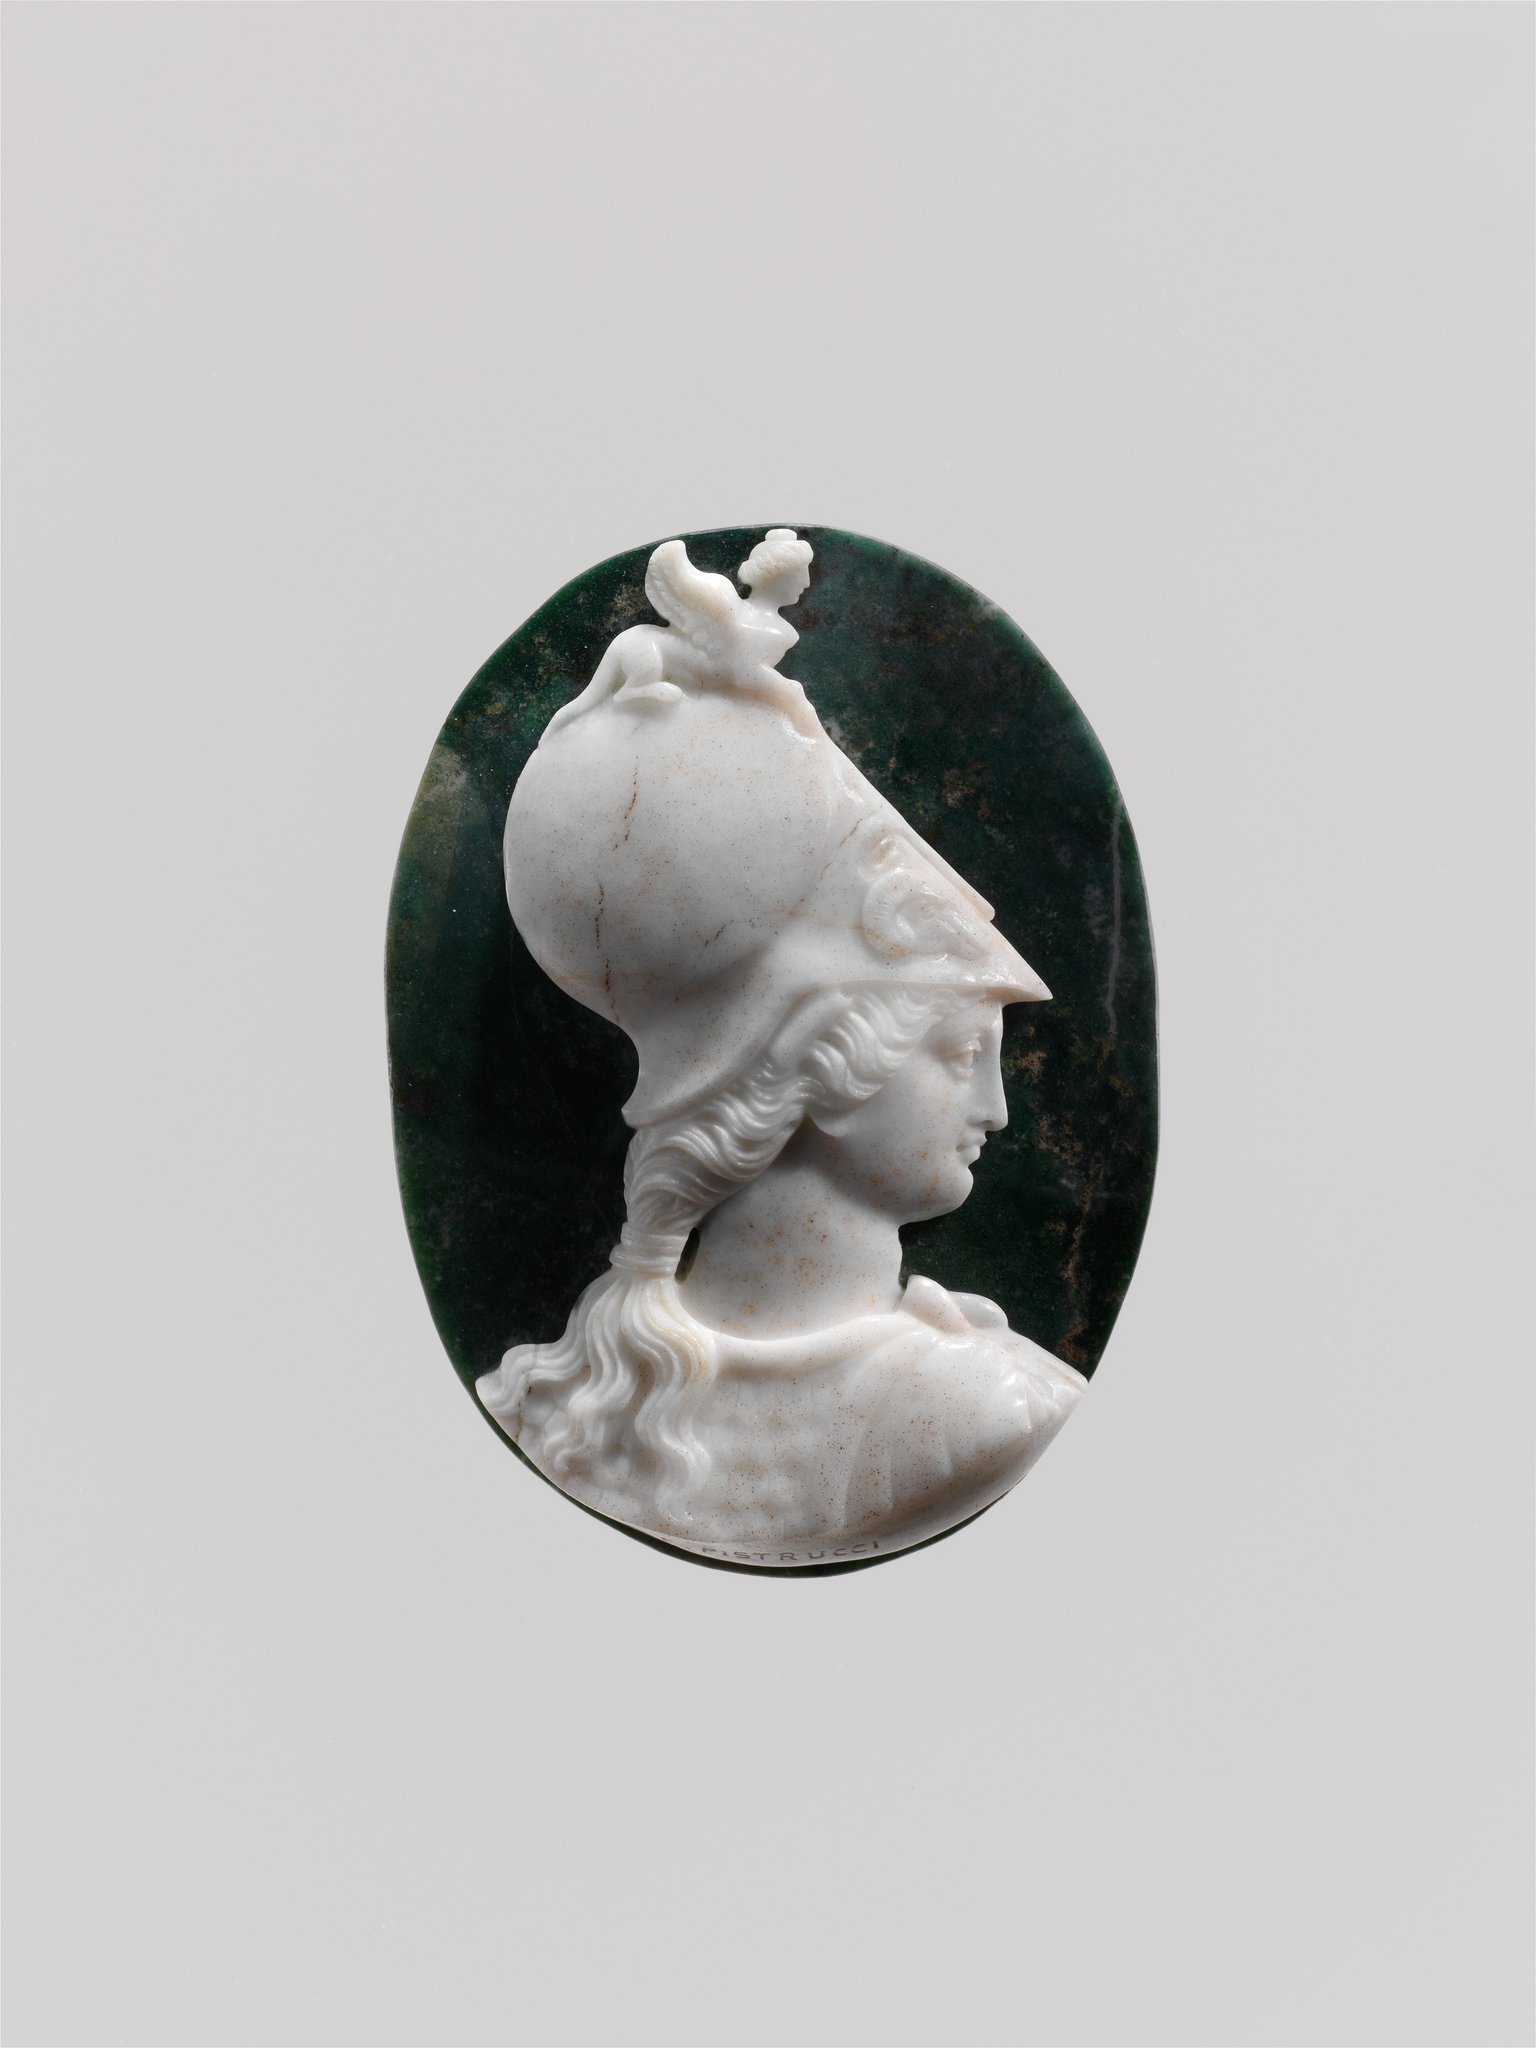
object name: cameo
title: Bust of Minerva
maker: elena pistrucci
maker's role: artist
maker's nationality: british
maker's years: 1822-1886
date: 1870-1880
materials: stone, onyx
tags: profiles,minerva